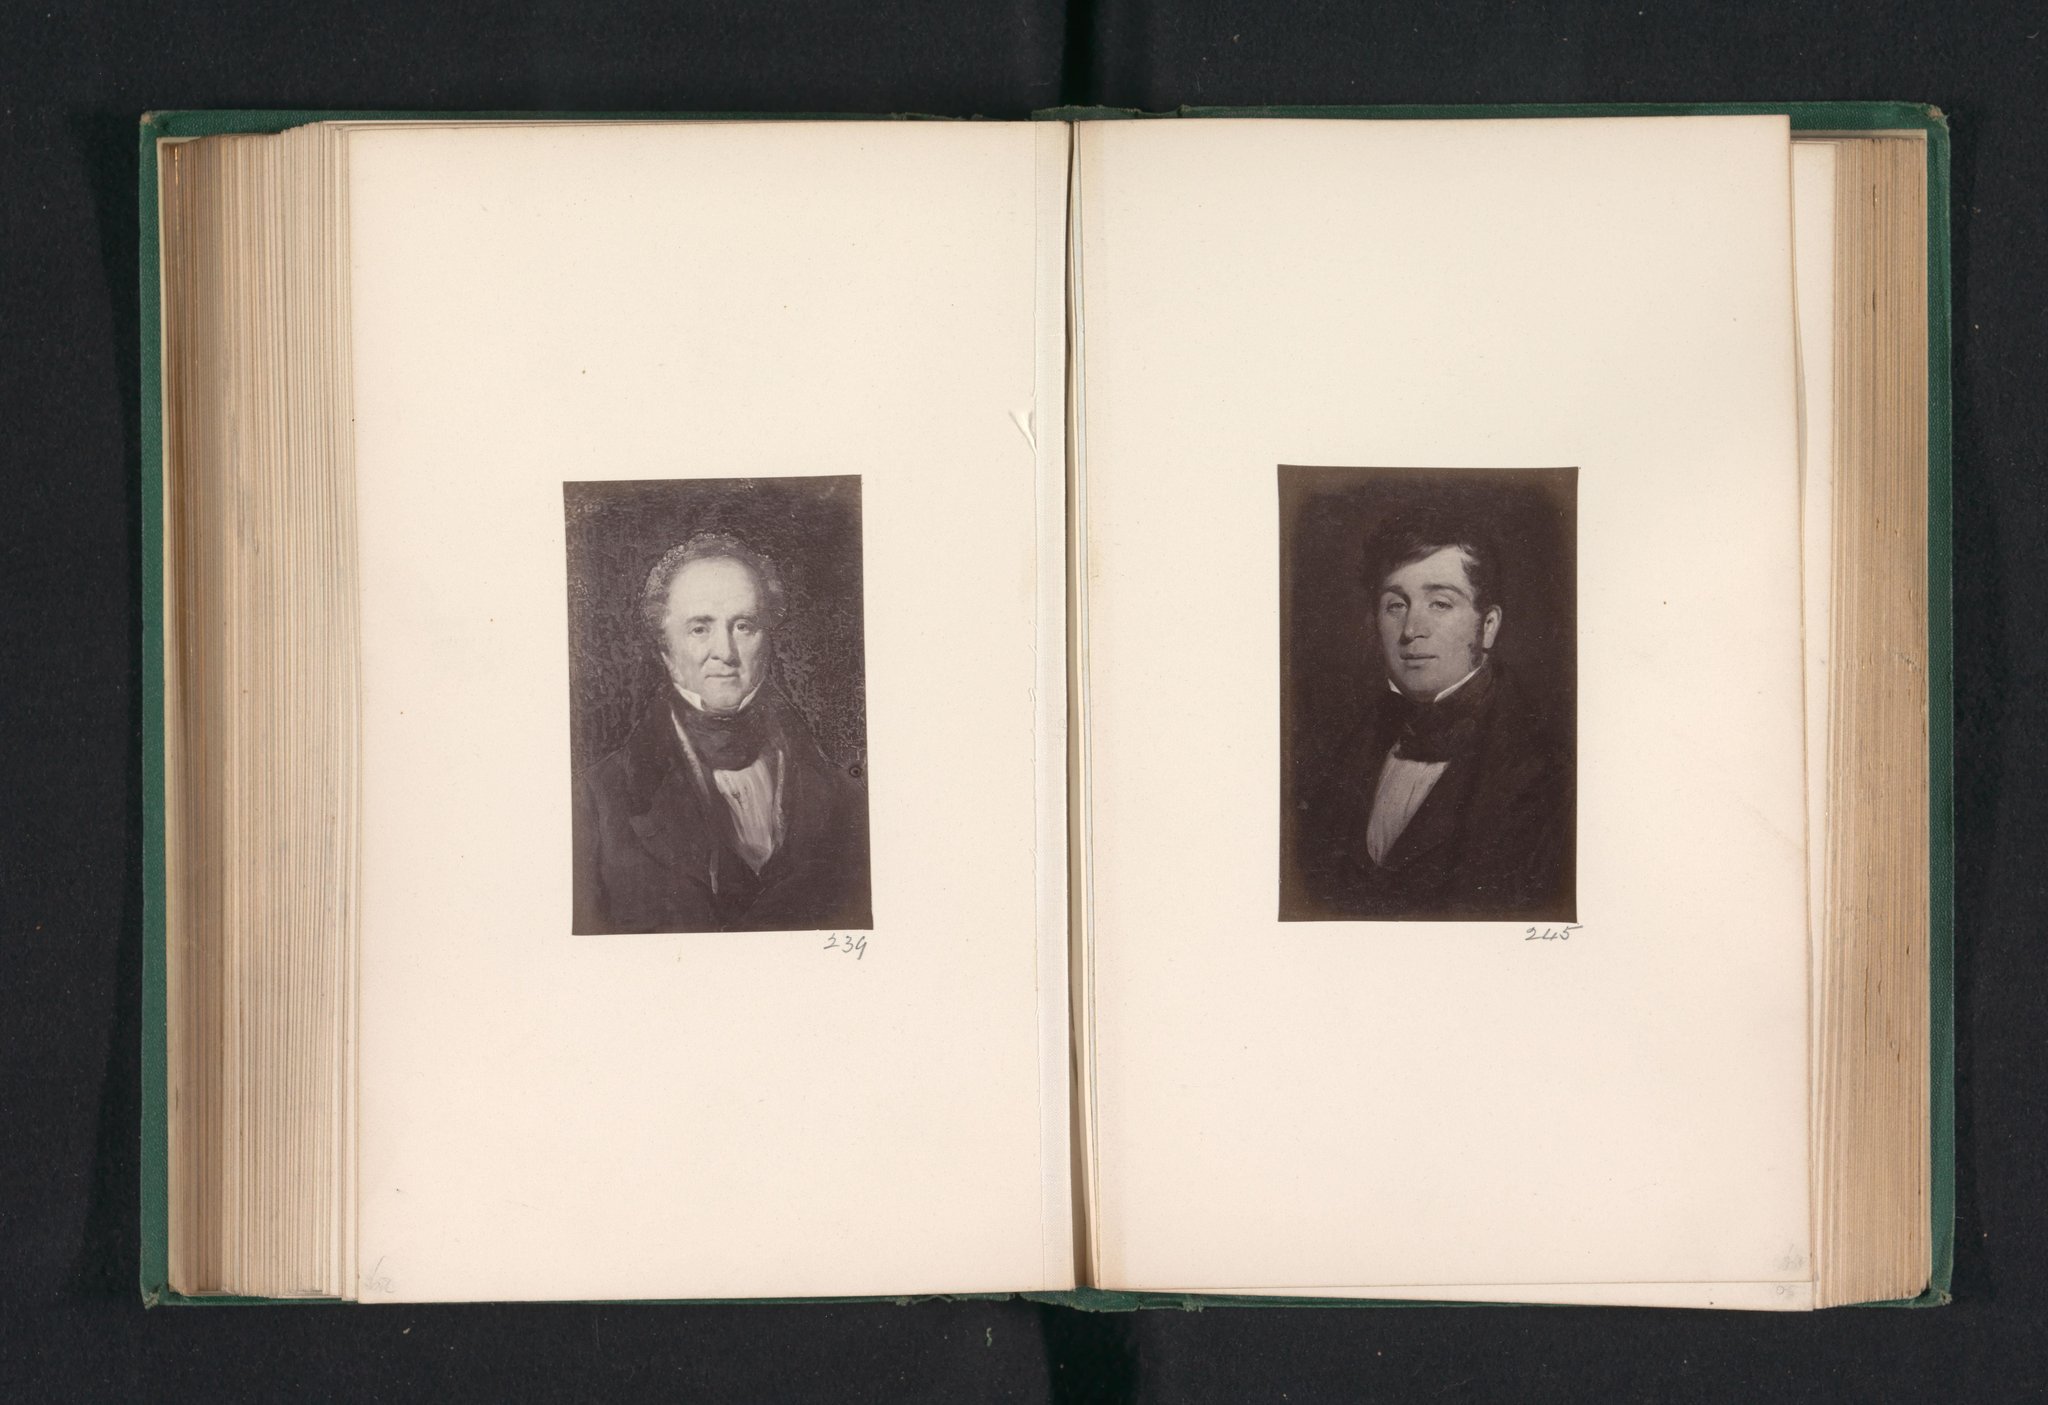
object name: page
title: Fotoreproductie van een schilderij, voorstellende een portret van Alexander Whitelaw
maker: thomas annan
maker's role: fotograaf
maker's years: 1829-1887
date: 1863-1868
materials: photographic support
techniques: albumen print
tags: historical persons (portraits and scenes from the life) (+ (full) bust portrait)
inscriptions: number: ‘234’